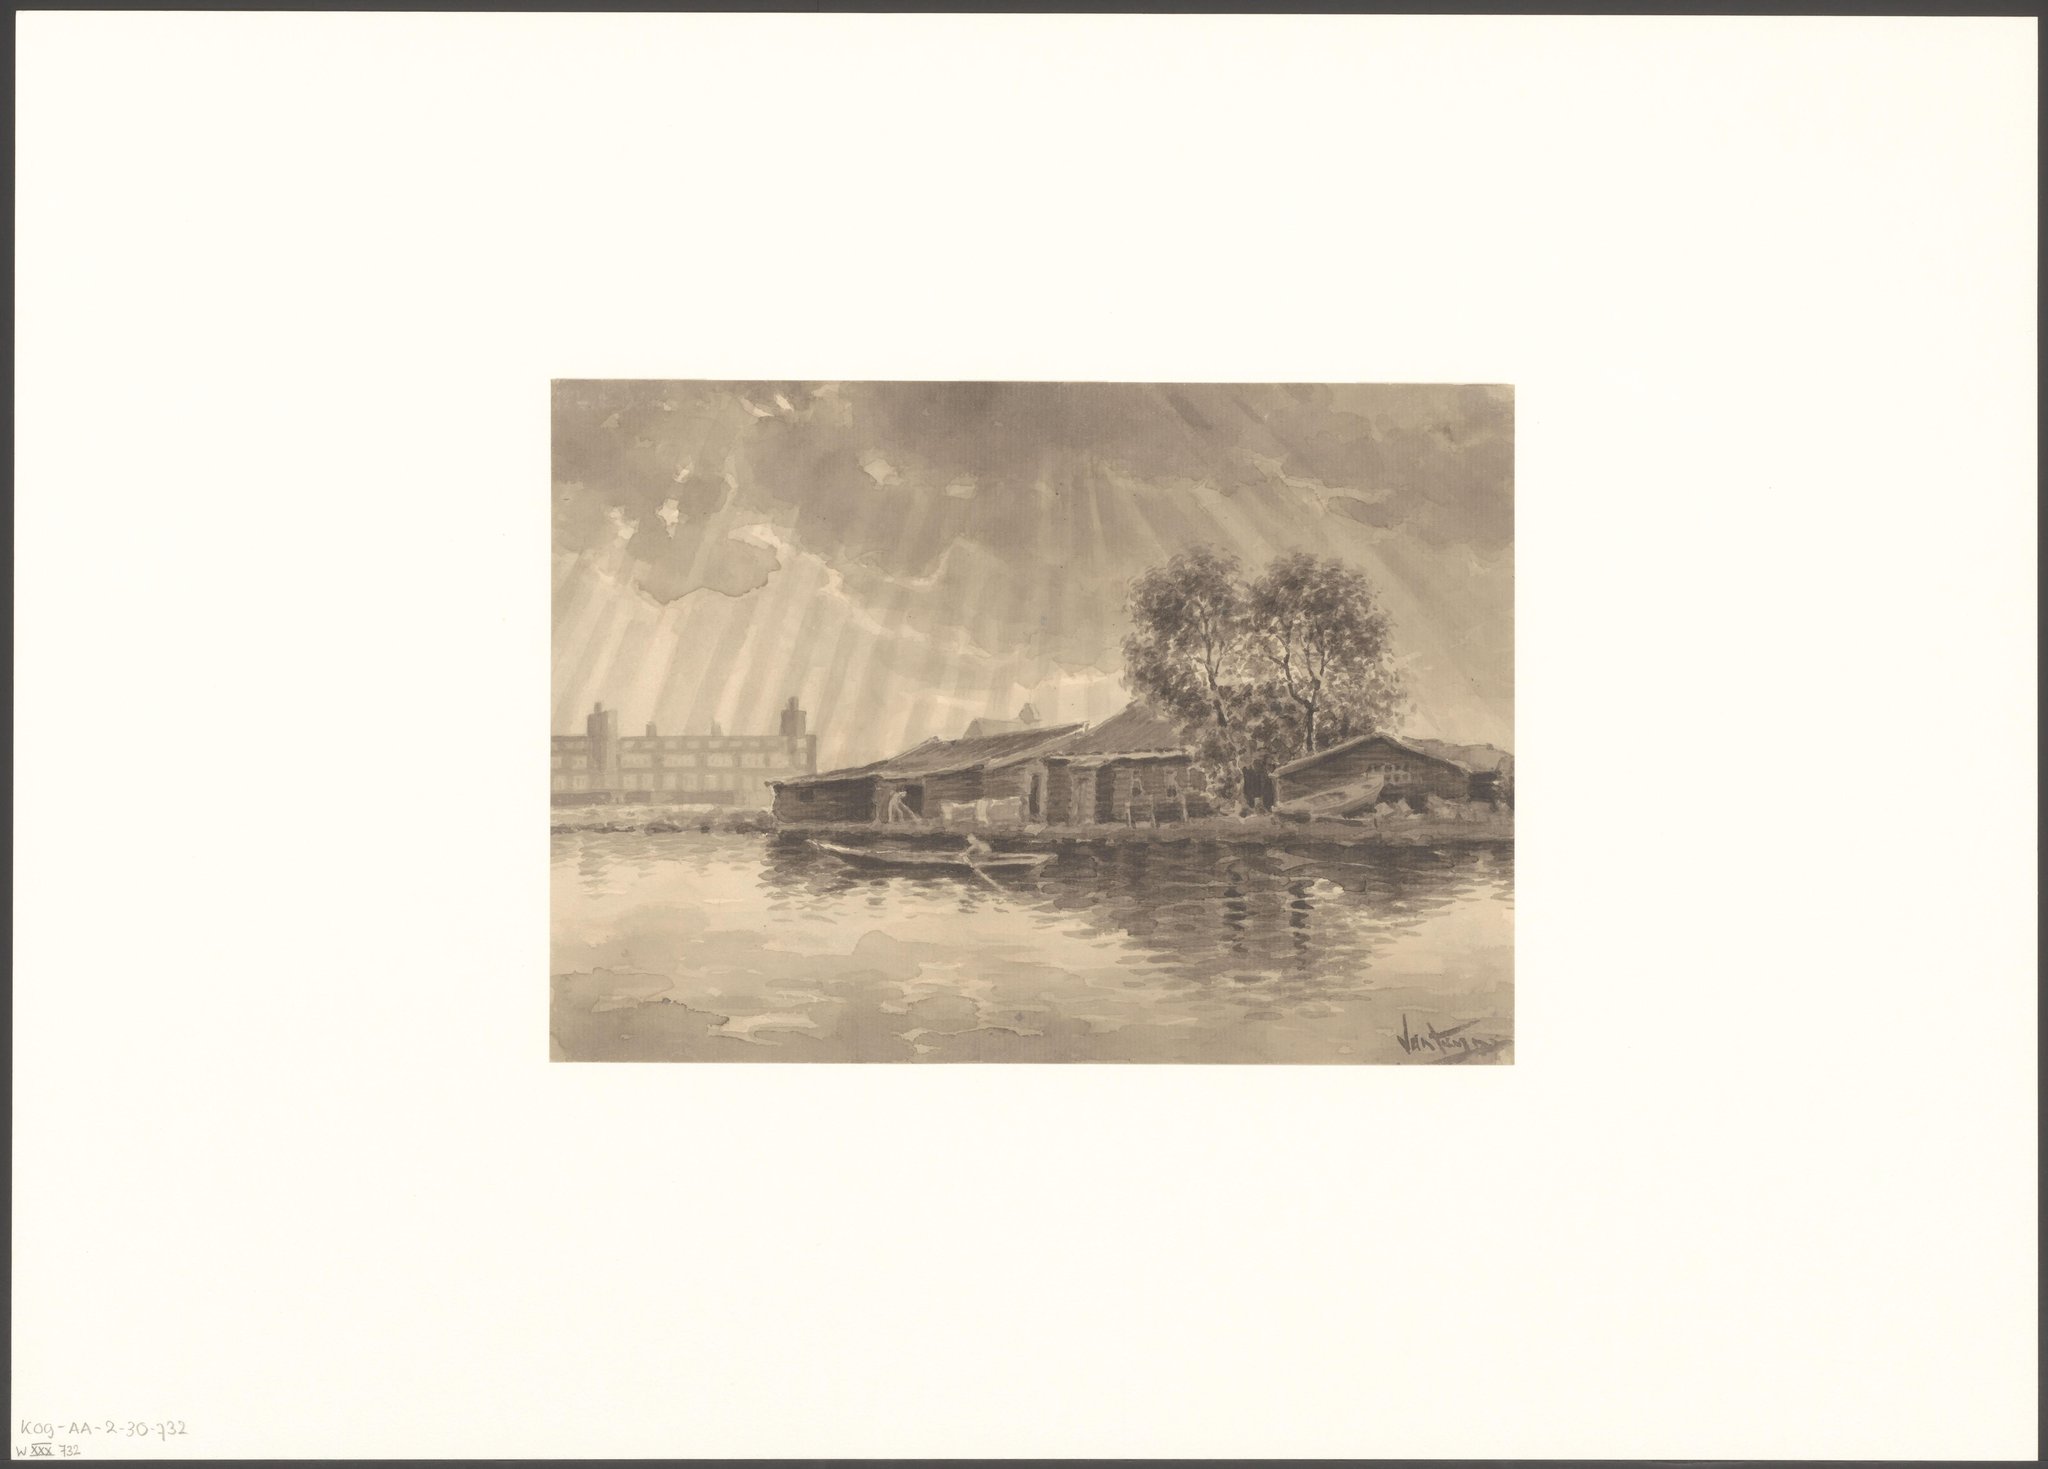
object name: drawing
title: Gezicht op het Terrein van Roos gezien vanaf de Tweede Kostverlorenkade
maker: anthonie van teijn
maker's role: draughtsman, painter, print maker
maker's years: 1863-1943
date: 1907-1927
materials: ink, paper, pencil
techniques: brush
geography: amsterdam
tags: city-view in general; 'veduta', canal, shed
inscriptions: collector's mark: Lugt 800a, inscription: ‘Het terrein van (...) van Teyn / vanEck’, signature: ‘VanTeyne’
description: Tekening binnen de Atlas Van Eck ingedeeld op wijknummer 30.